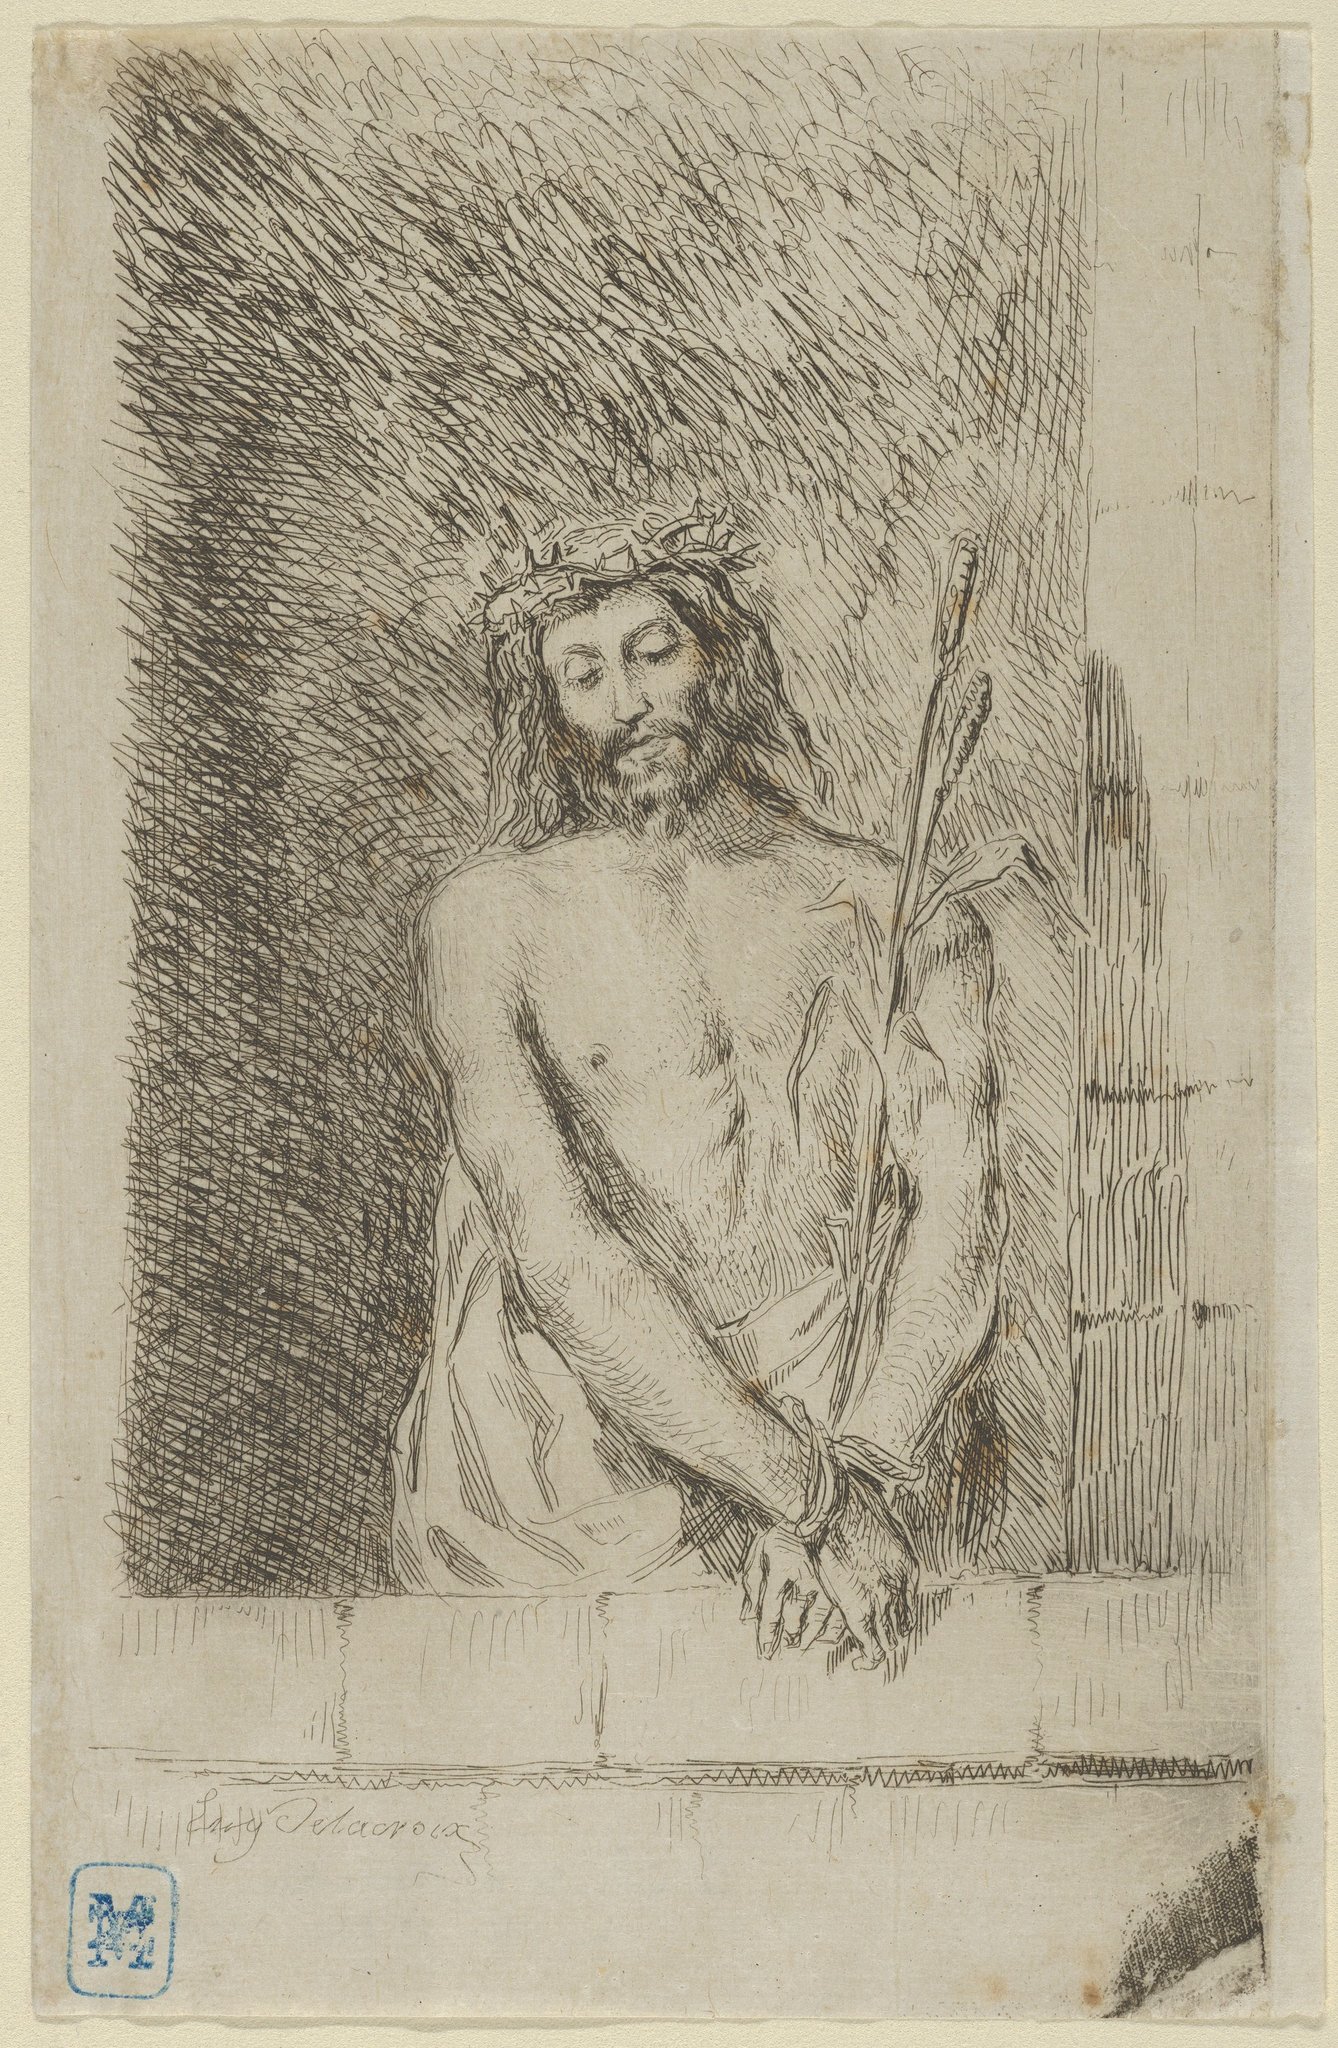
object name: print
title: Ecce Homo (Christ with the Reed)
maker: eugène delacroix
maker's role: artist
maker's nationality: french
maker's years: 1798-1863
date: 1833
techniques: etching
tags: christ